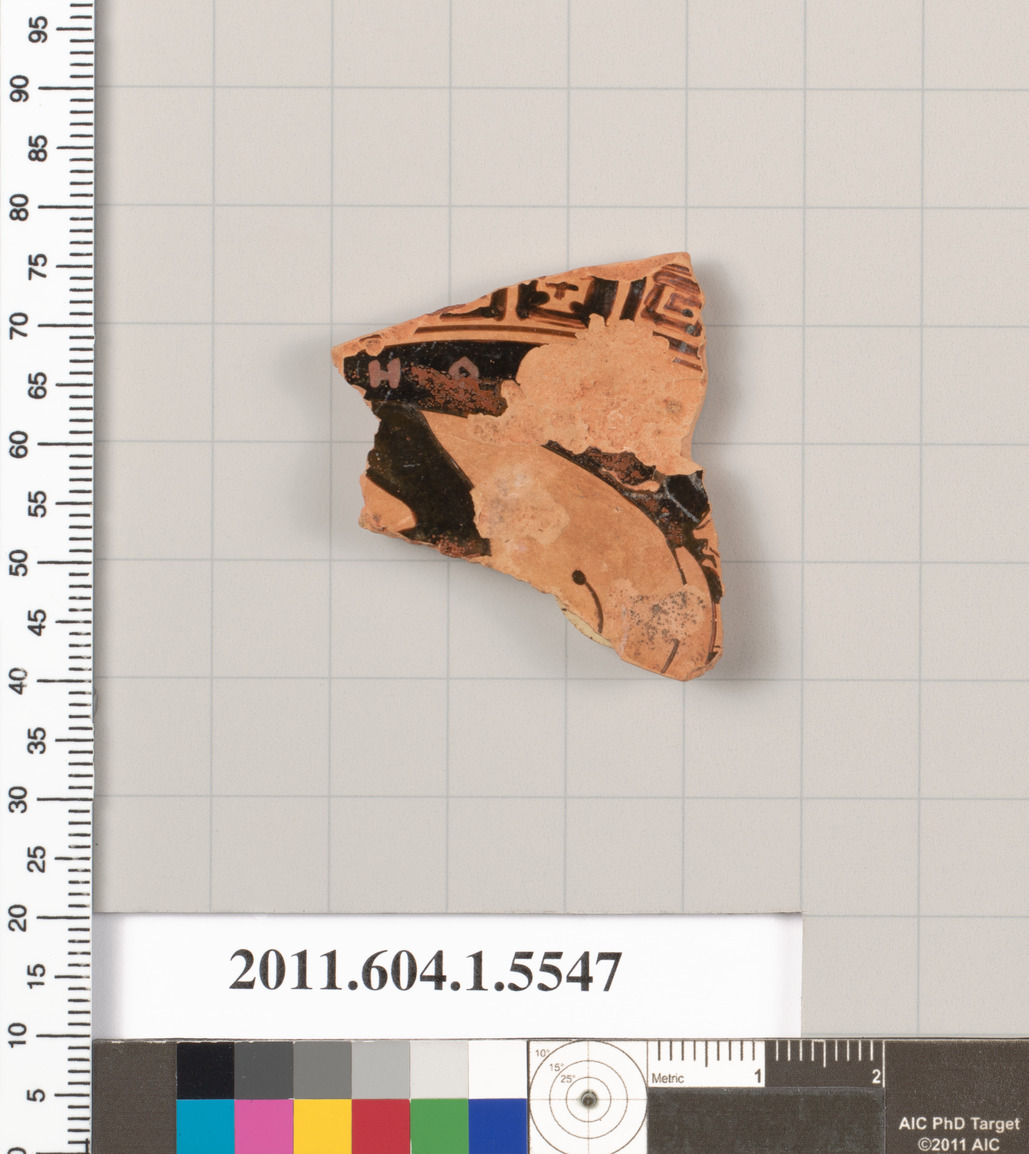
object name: kylix fragment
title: Terracotta fragment of a kylix (drinking cup)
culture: greek, attic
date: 500-480 BCE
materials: terracotta